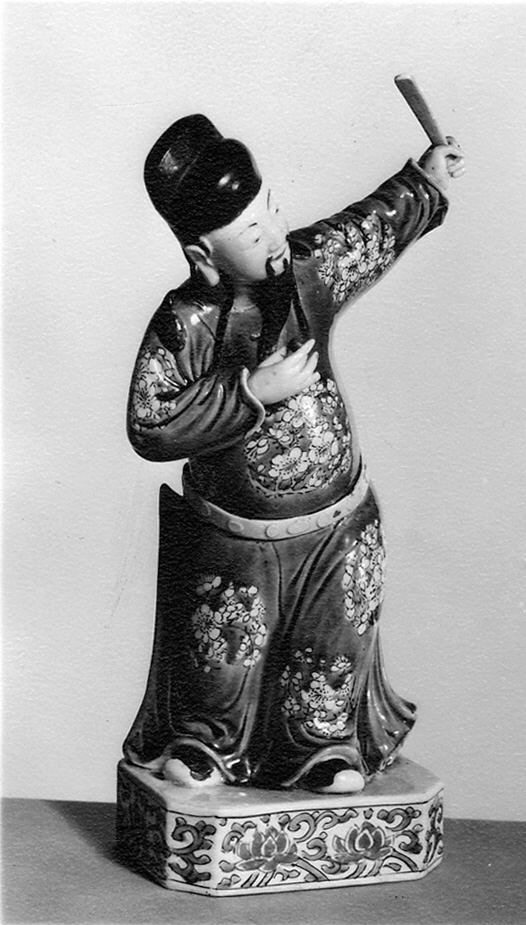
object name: figure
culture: chinese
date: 1662-1722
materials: porcelain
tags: men